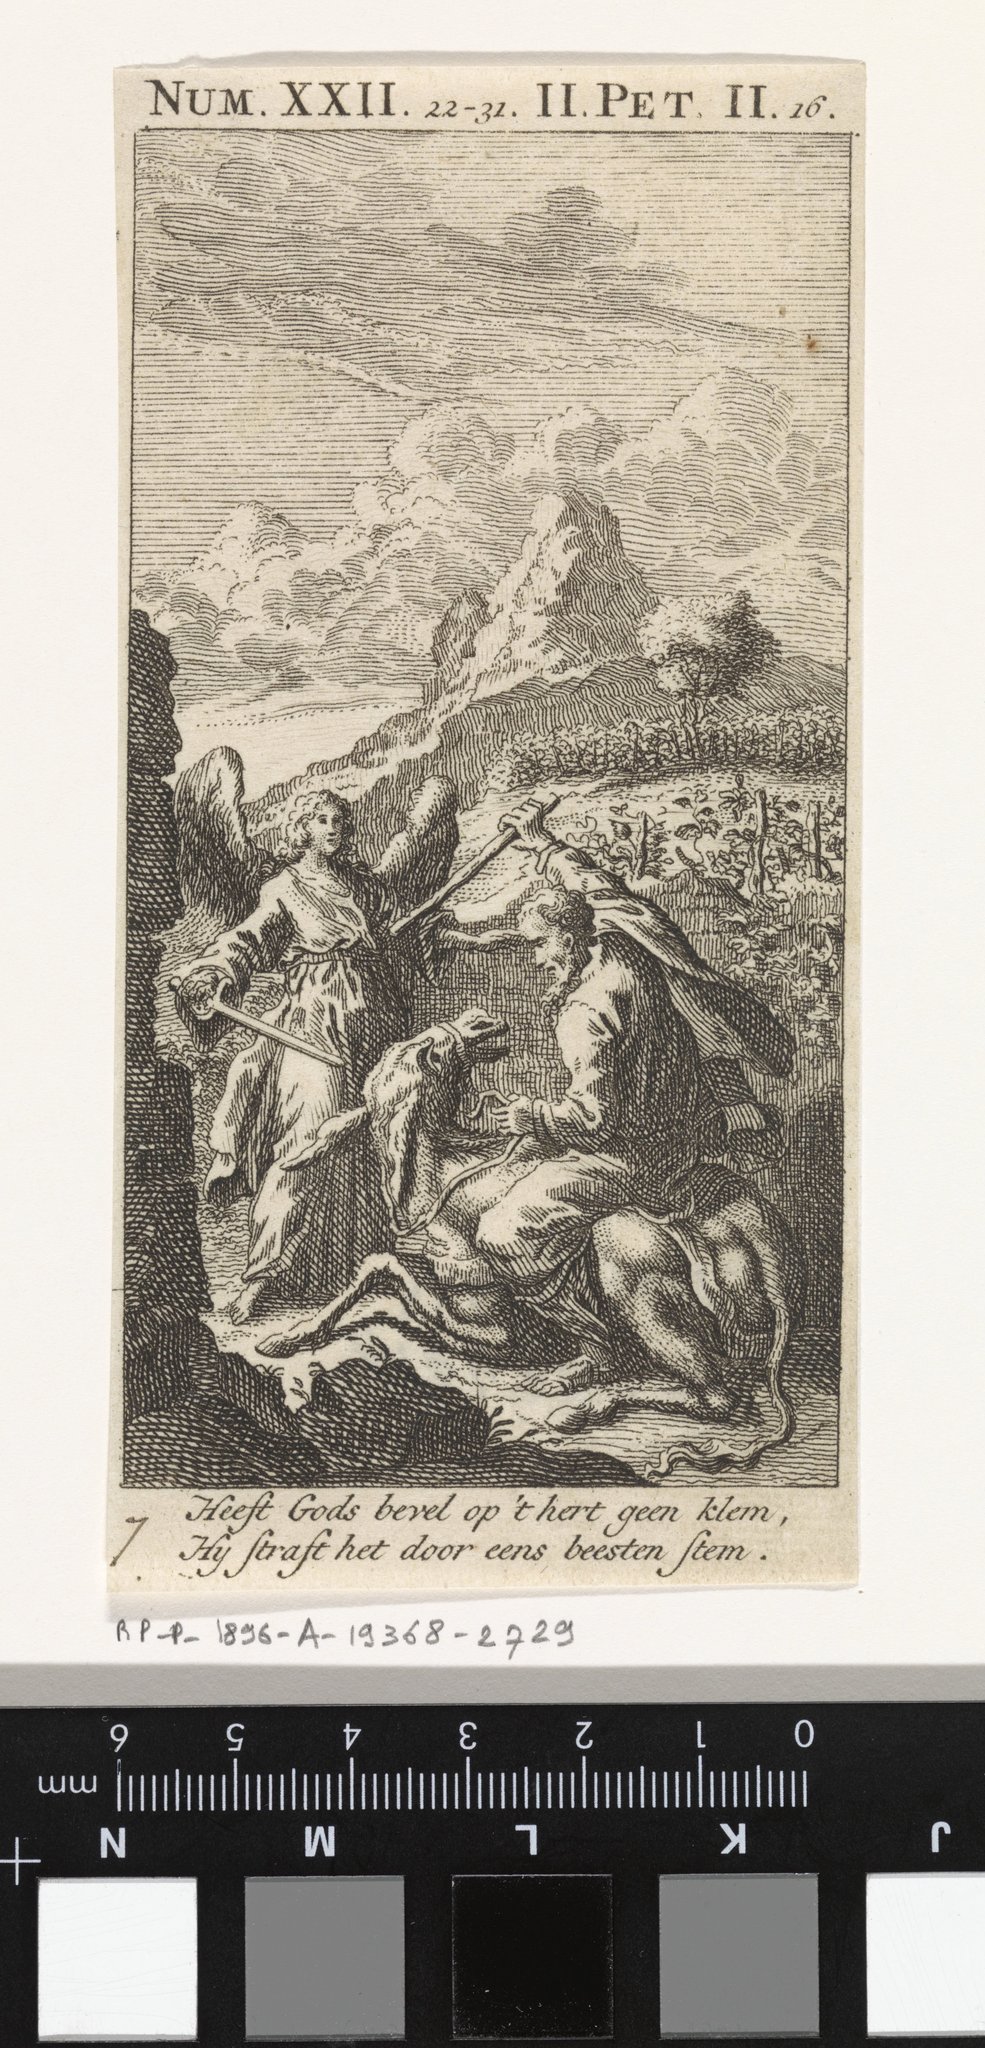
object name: print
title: Bileam en zijn ezel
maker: jan luyken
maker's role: draughtsman, print maker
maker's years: 1649-1712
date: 1712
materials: paper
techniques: etching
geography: amsterdam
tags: an angel holding a sword bars the way and causes balaam's ass to turn aside; the angel is invisible to balaam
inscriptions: collector's mark: Lugt 2228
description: Variant op illustratie voor: Luyken, Jan. Bybel printen. Amsterdam: Pieter Arentsz. II (wed.) en Cornelis van der Sys, 1712, p. 7.